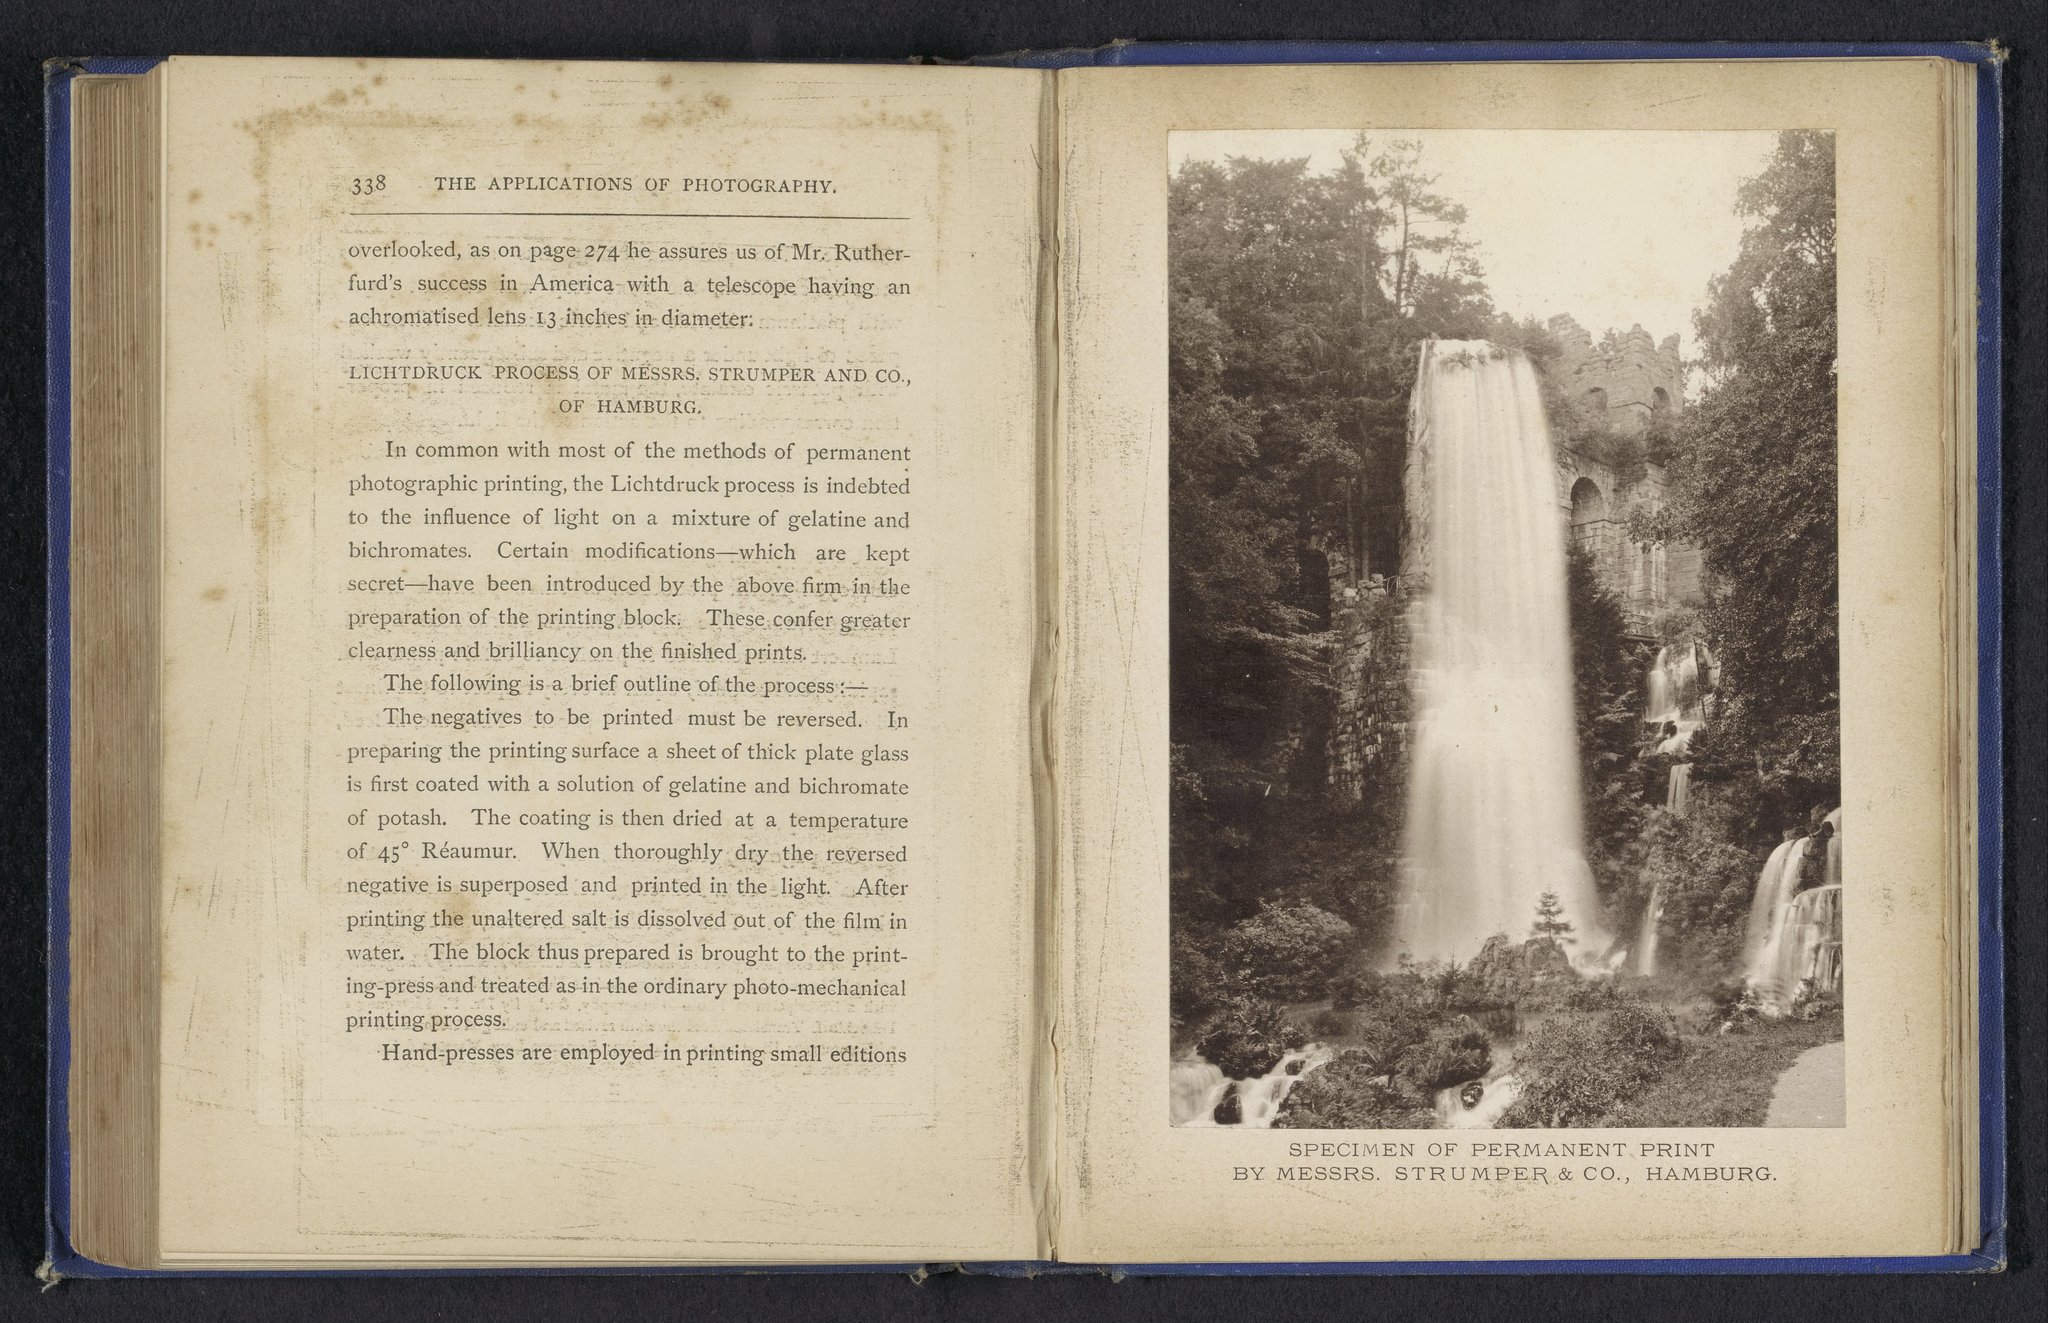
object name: page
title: Waterval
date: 1868-1878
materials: paper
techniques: photograph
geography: hamburg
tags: waterfall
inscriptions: inscription: ‘Specimen of permanent print by Messrs. Strumper & Co., Hamburg’